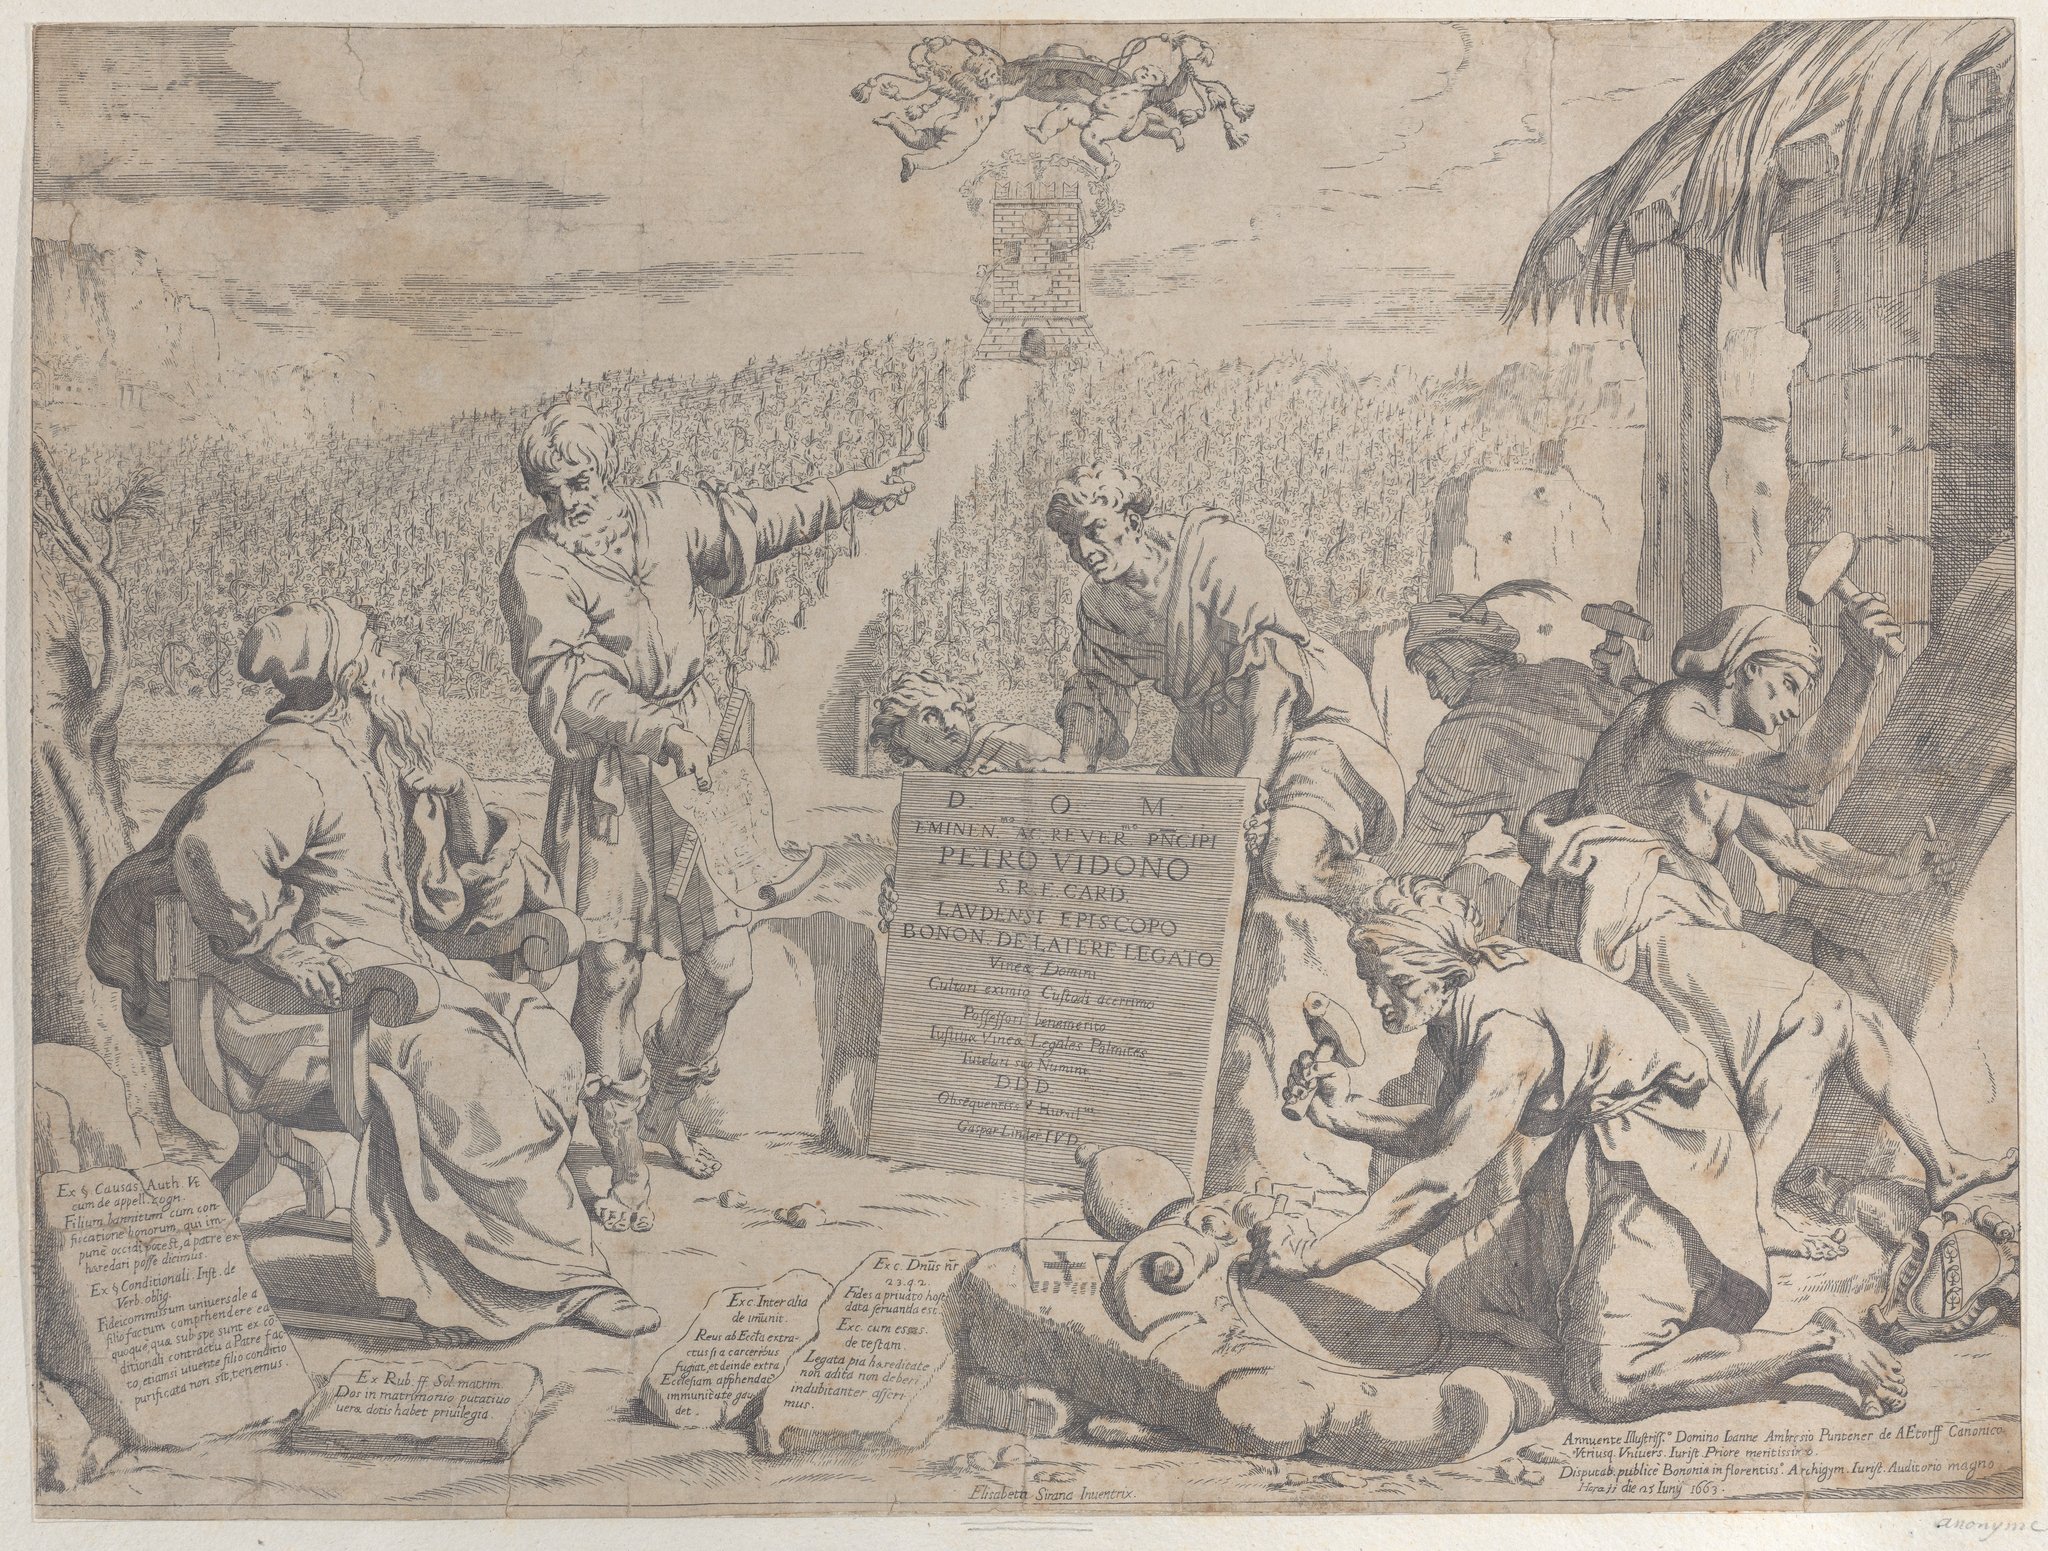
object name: print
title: Stonemasons carving the arms of the Bolognese Cardinal Petro Vidono, under his direction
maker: Anonymous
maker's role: artist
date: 1663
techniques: etching